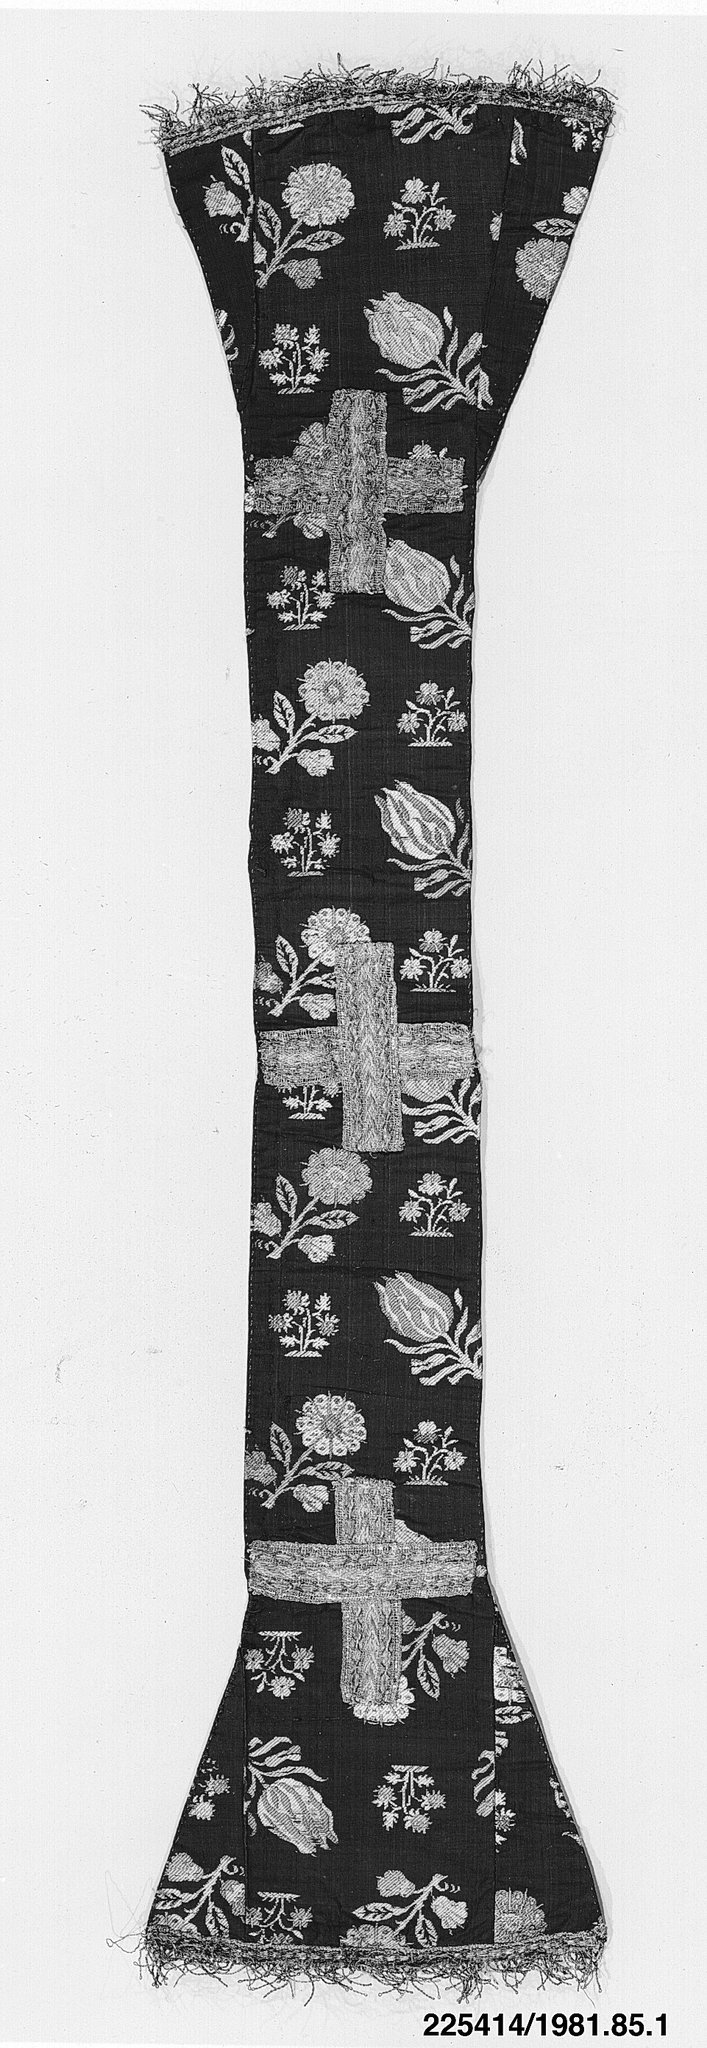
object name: maniple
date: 1634-1666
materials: metal thread, silk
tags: flowers,cross